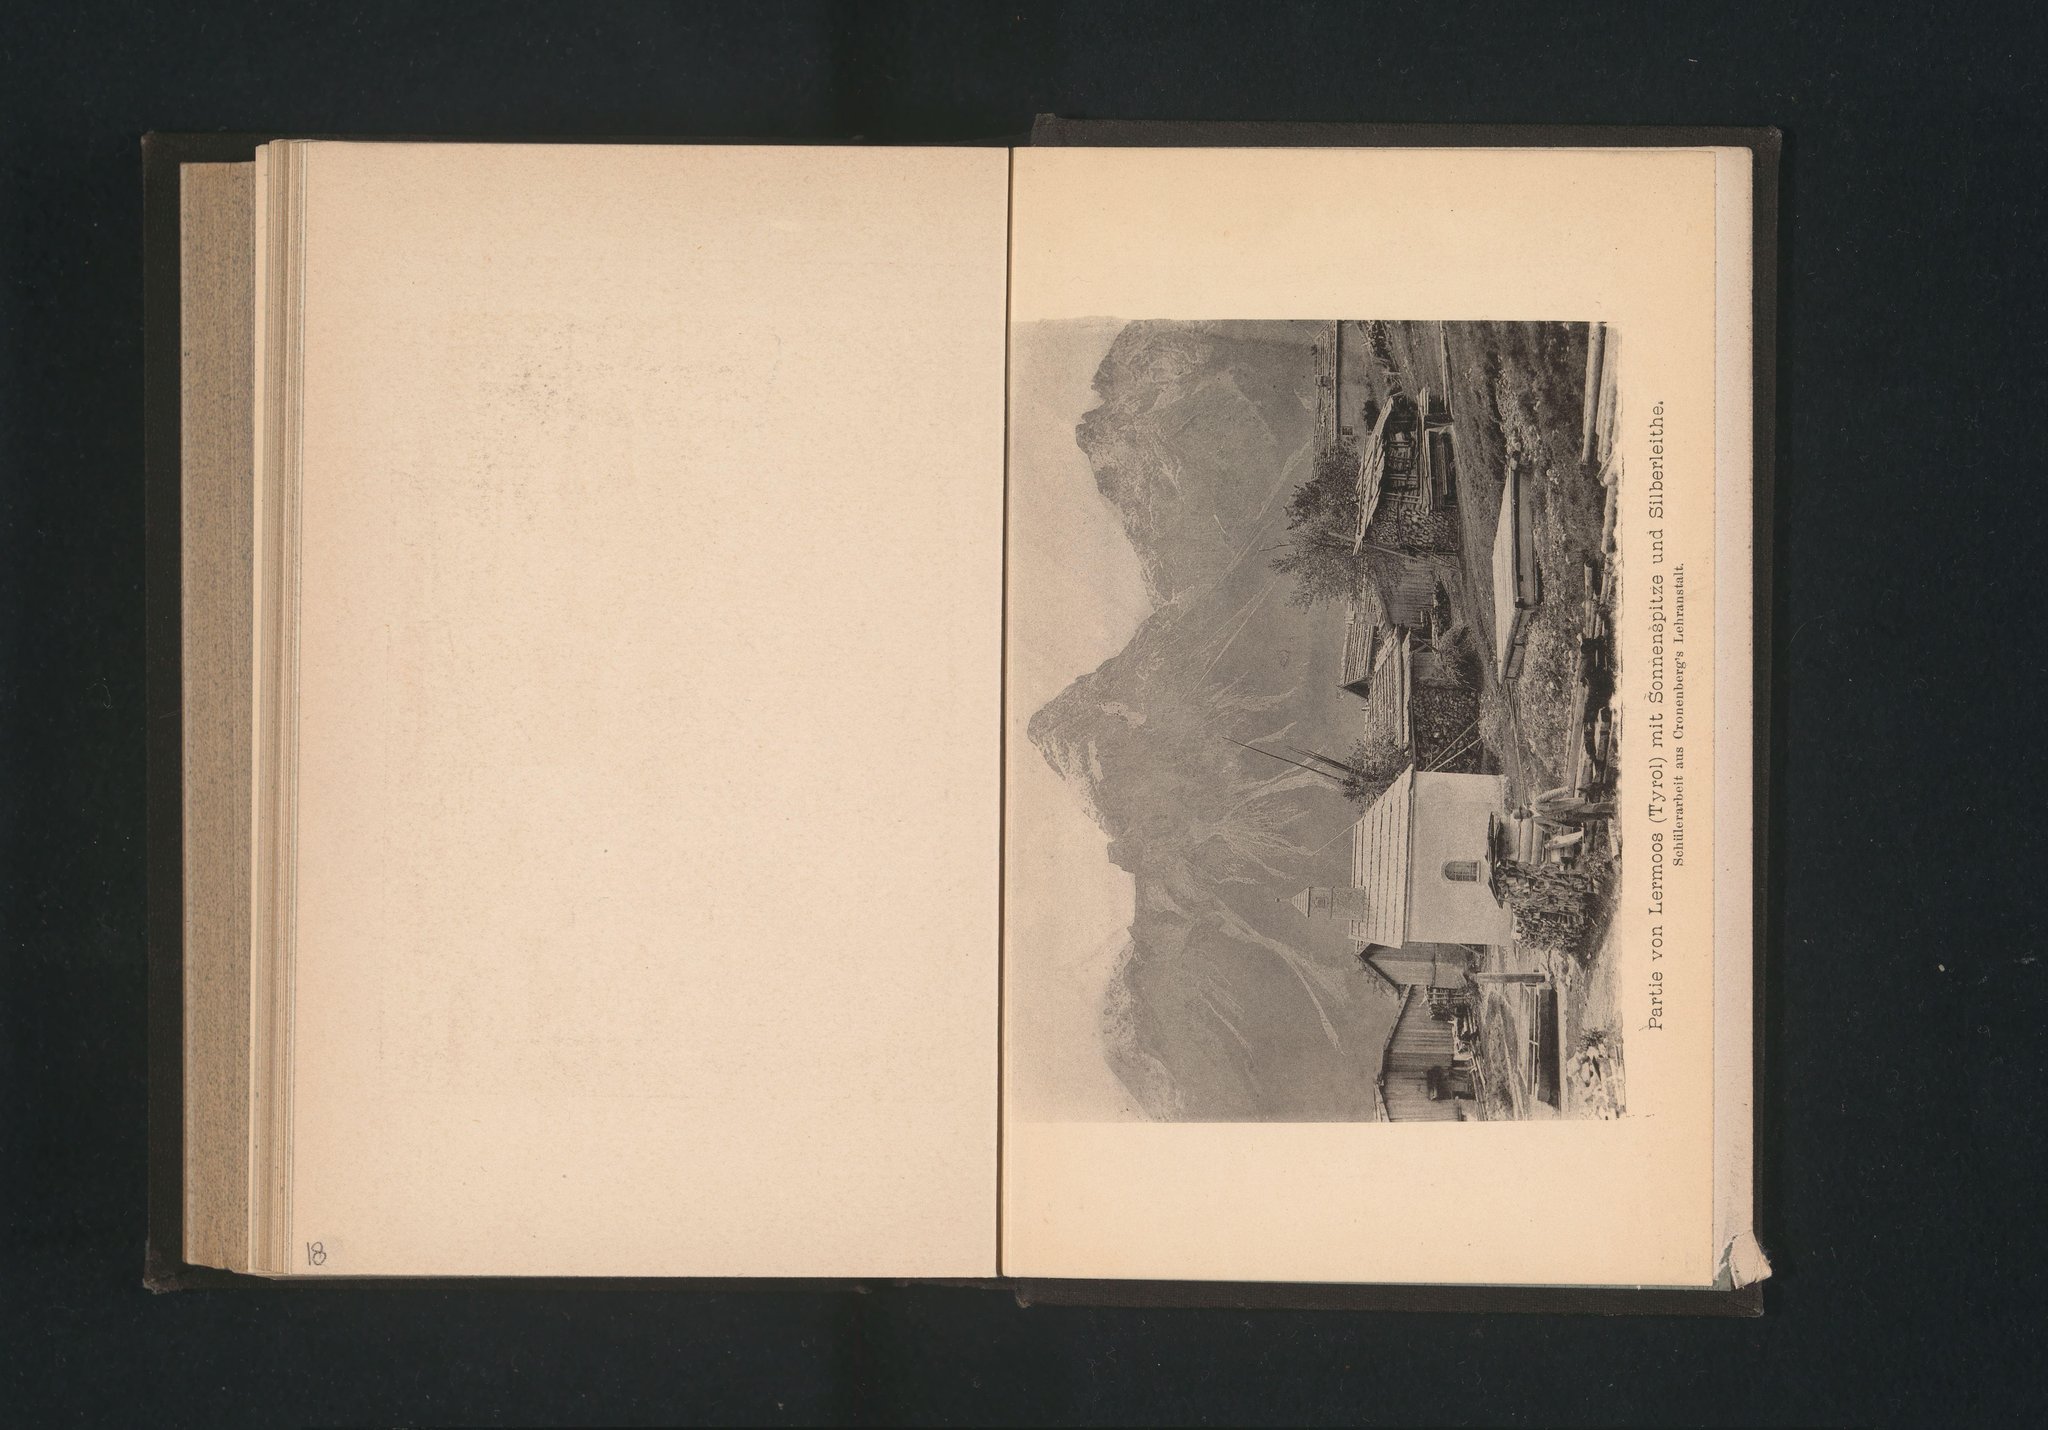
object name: page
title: Gezicht op Lermoos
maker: Anonymous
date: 1886-1891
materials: paper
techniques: photograph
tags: mountains (+ landscape with figures, staffage)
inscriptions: inscription: ‘Partie von Lermoos (Tyrol) mit Sonnenspitze und Silberleithe/ Schülerarbeit aus Cronenberg's Lehranstalt’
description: Prent op zesenveertigste ongenummerde pagina na pagina 627.